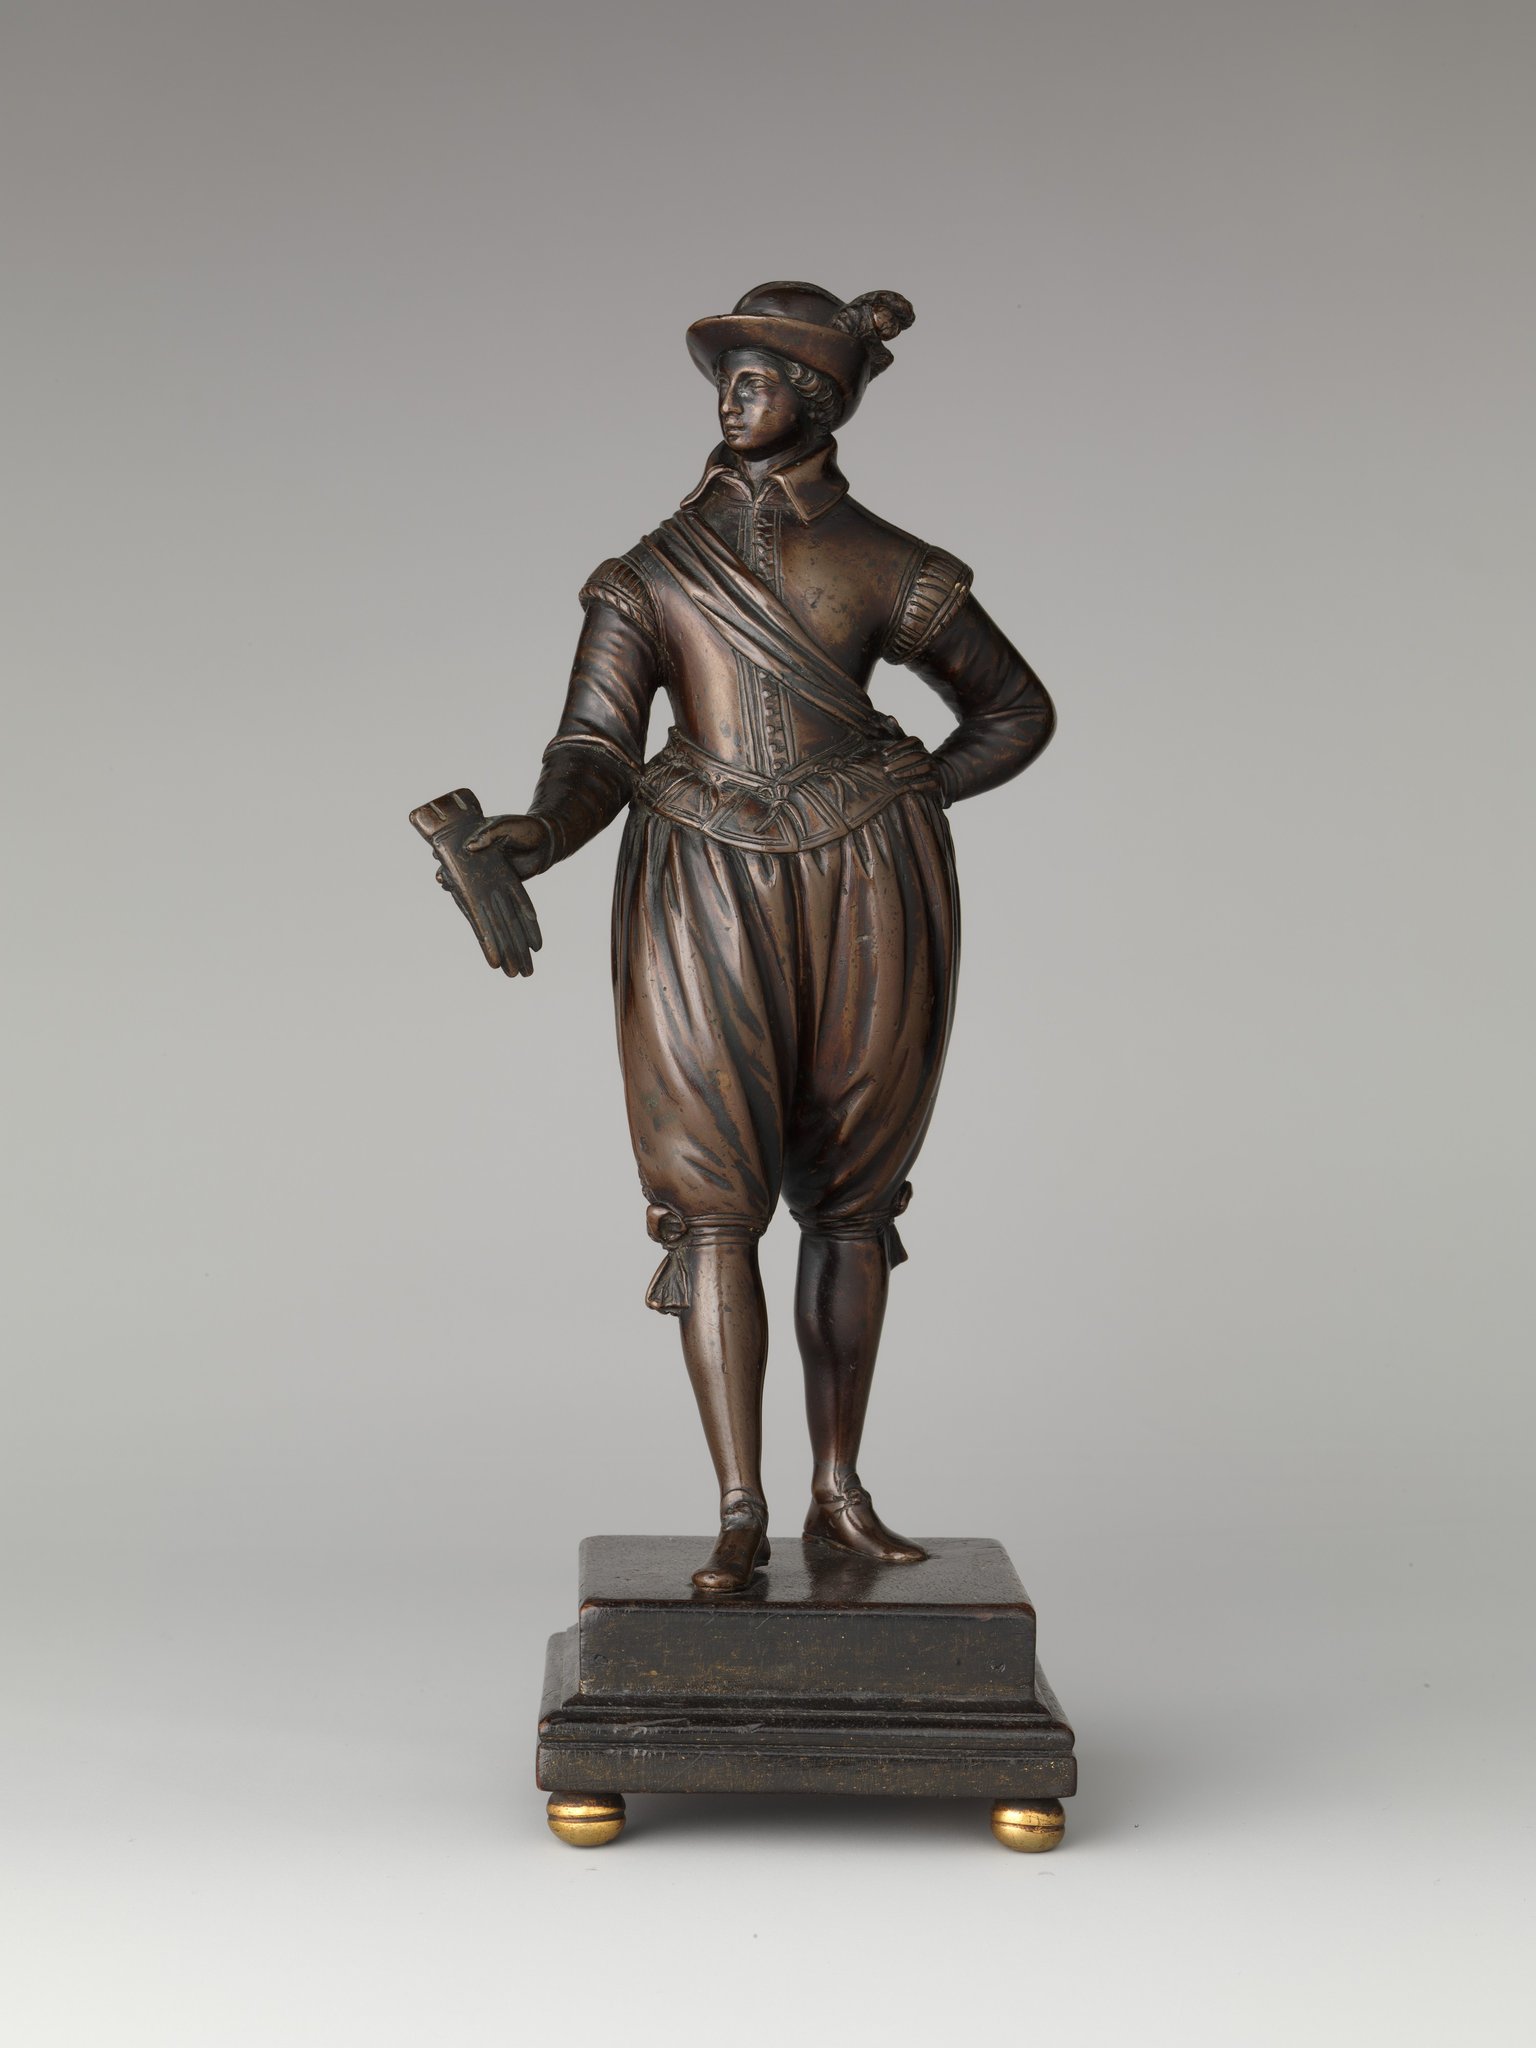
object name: statuette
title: Cavalier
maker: barthélemy prieur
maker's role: artist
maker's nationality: french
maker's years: 1536-1611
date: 1585-1594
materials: bronze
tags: men